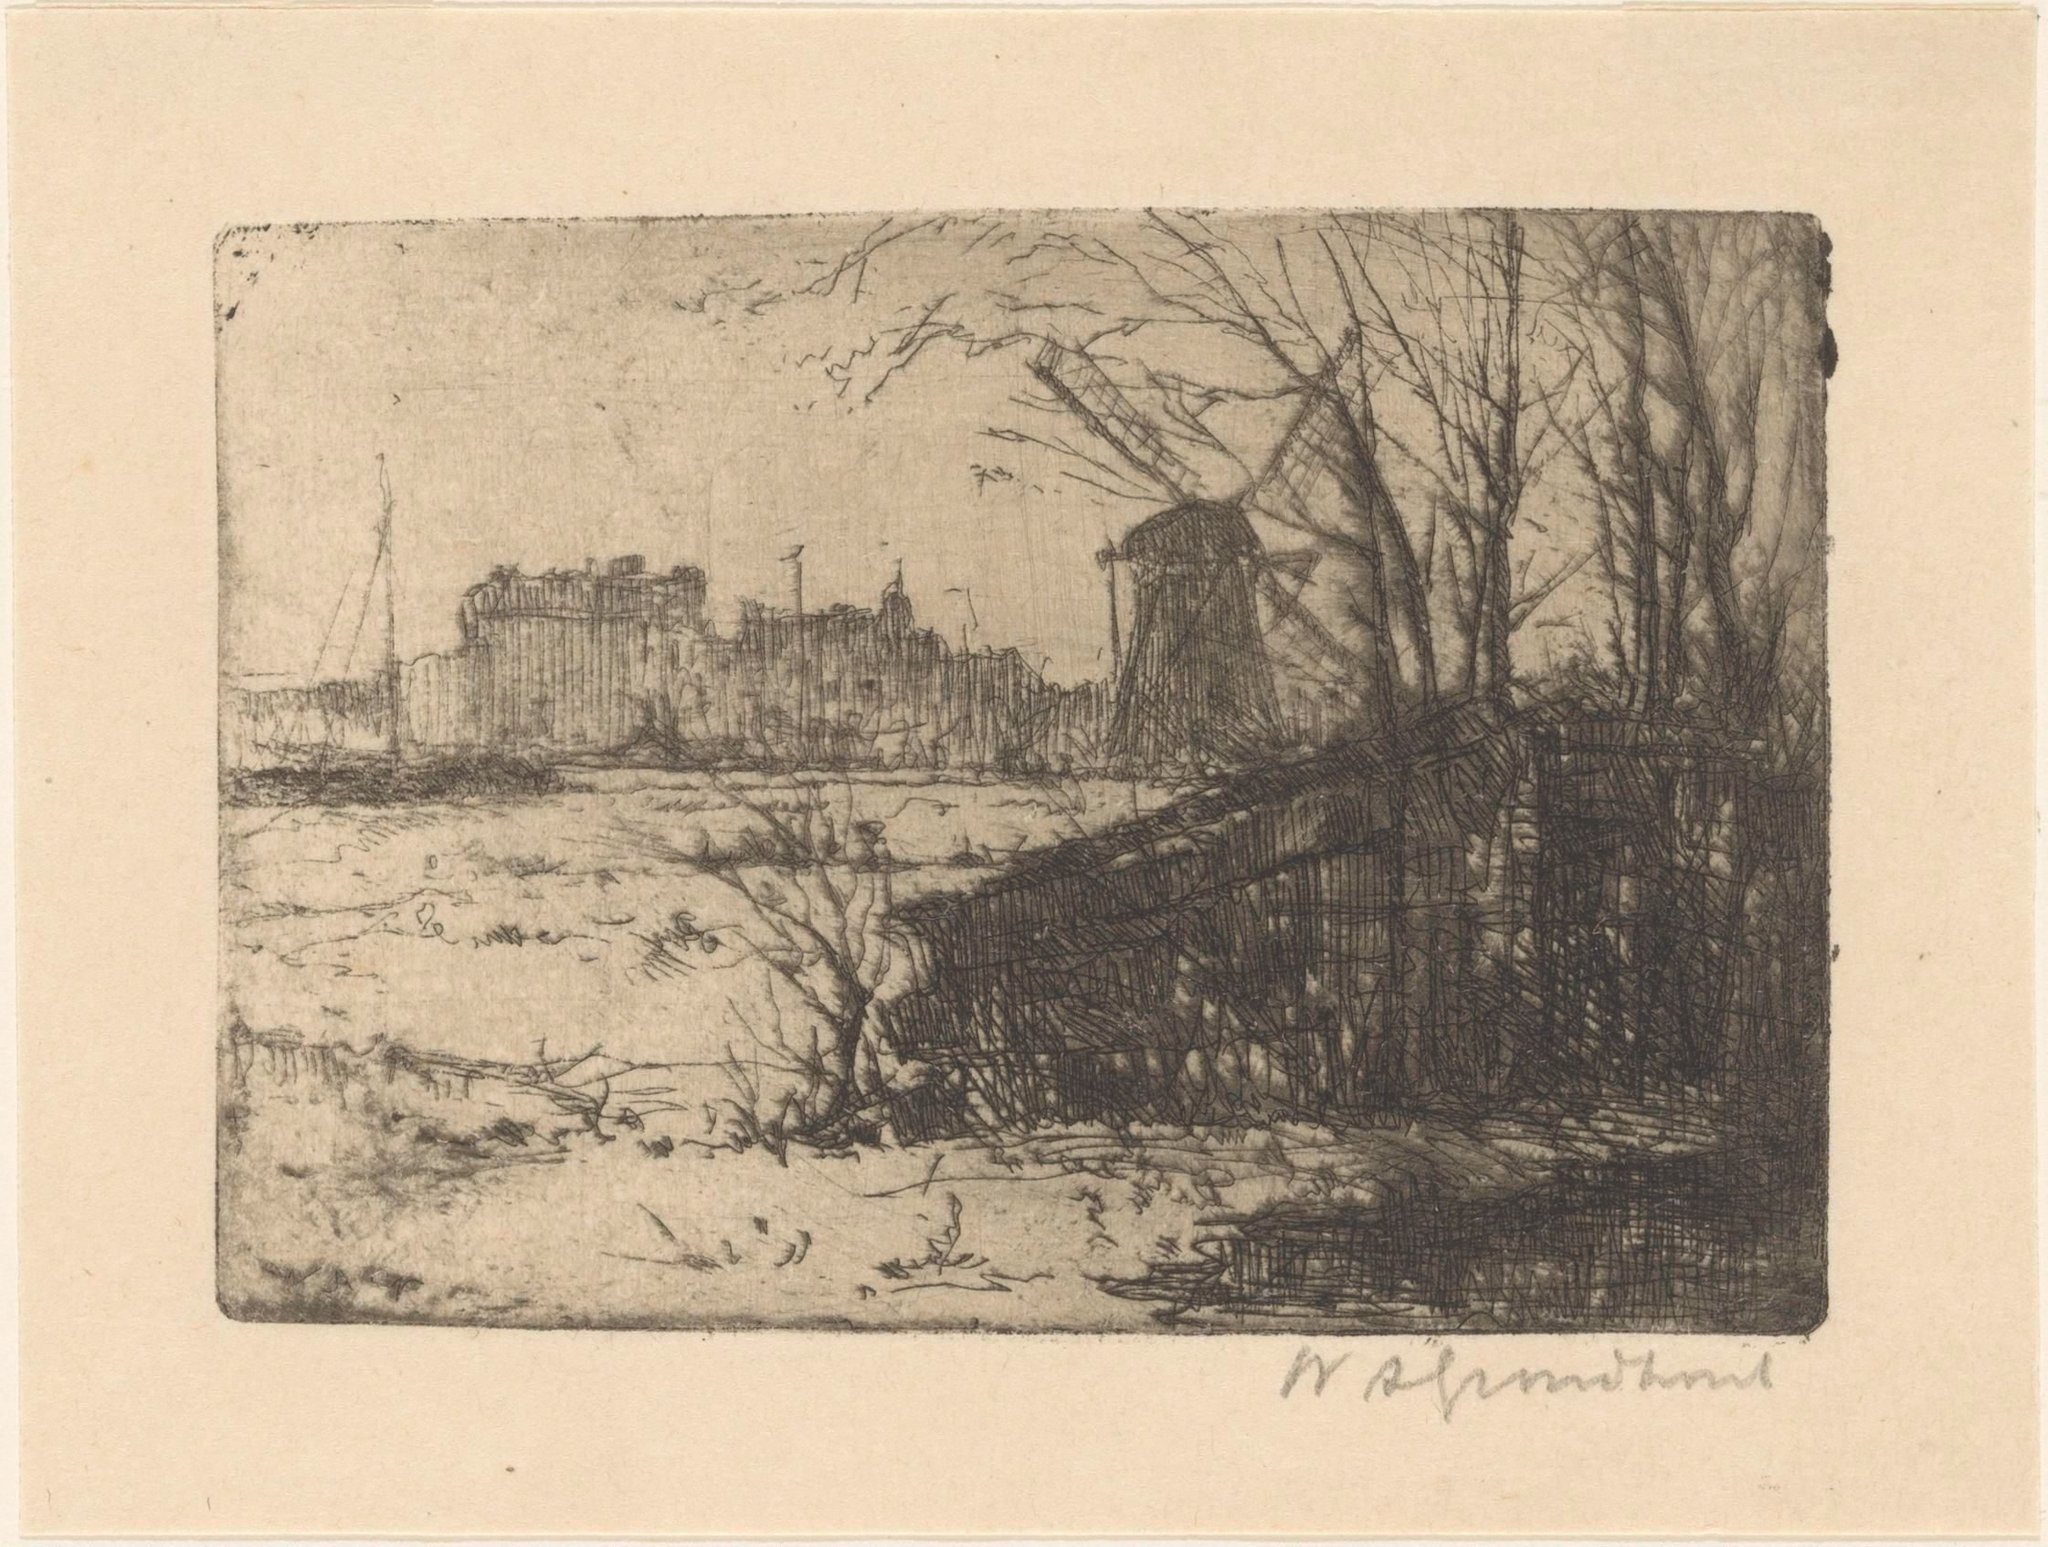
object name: print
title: Landschap met molen in de Binckhorst in Den Haag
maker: willem adrianus grondhout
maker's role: draughtsman, painter, print maker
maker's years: 1878-1934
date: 1916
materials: paper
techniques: etching, intaglio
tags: trees (+ bare plant), windmill in landscape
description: Op de voorgrond kale bomen. Op de achtergrond het silhouet van een molen en andere gebouwen.